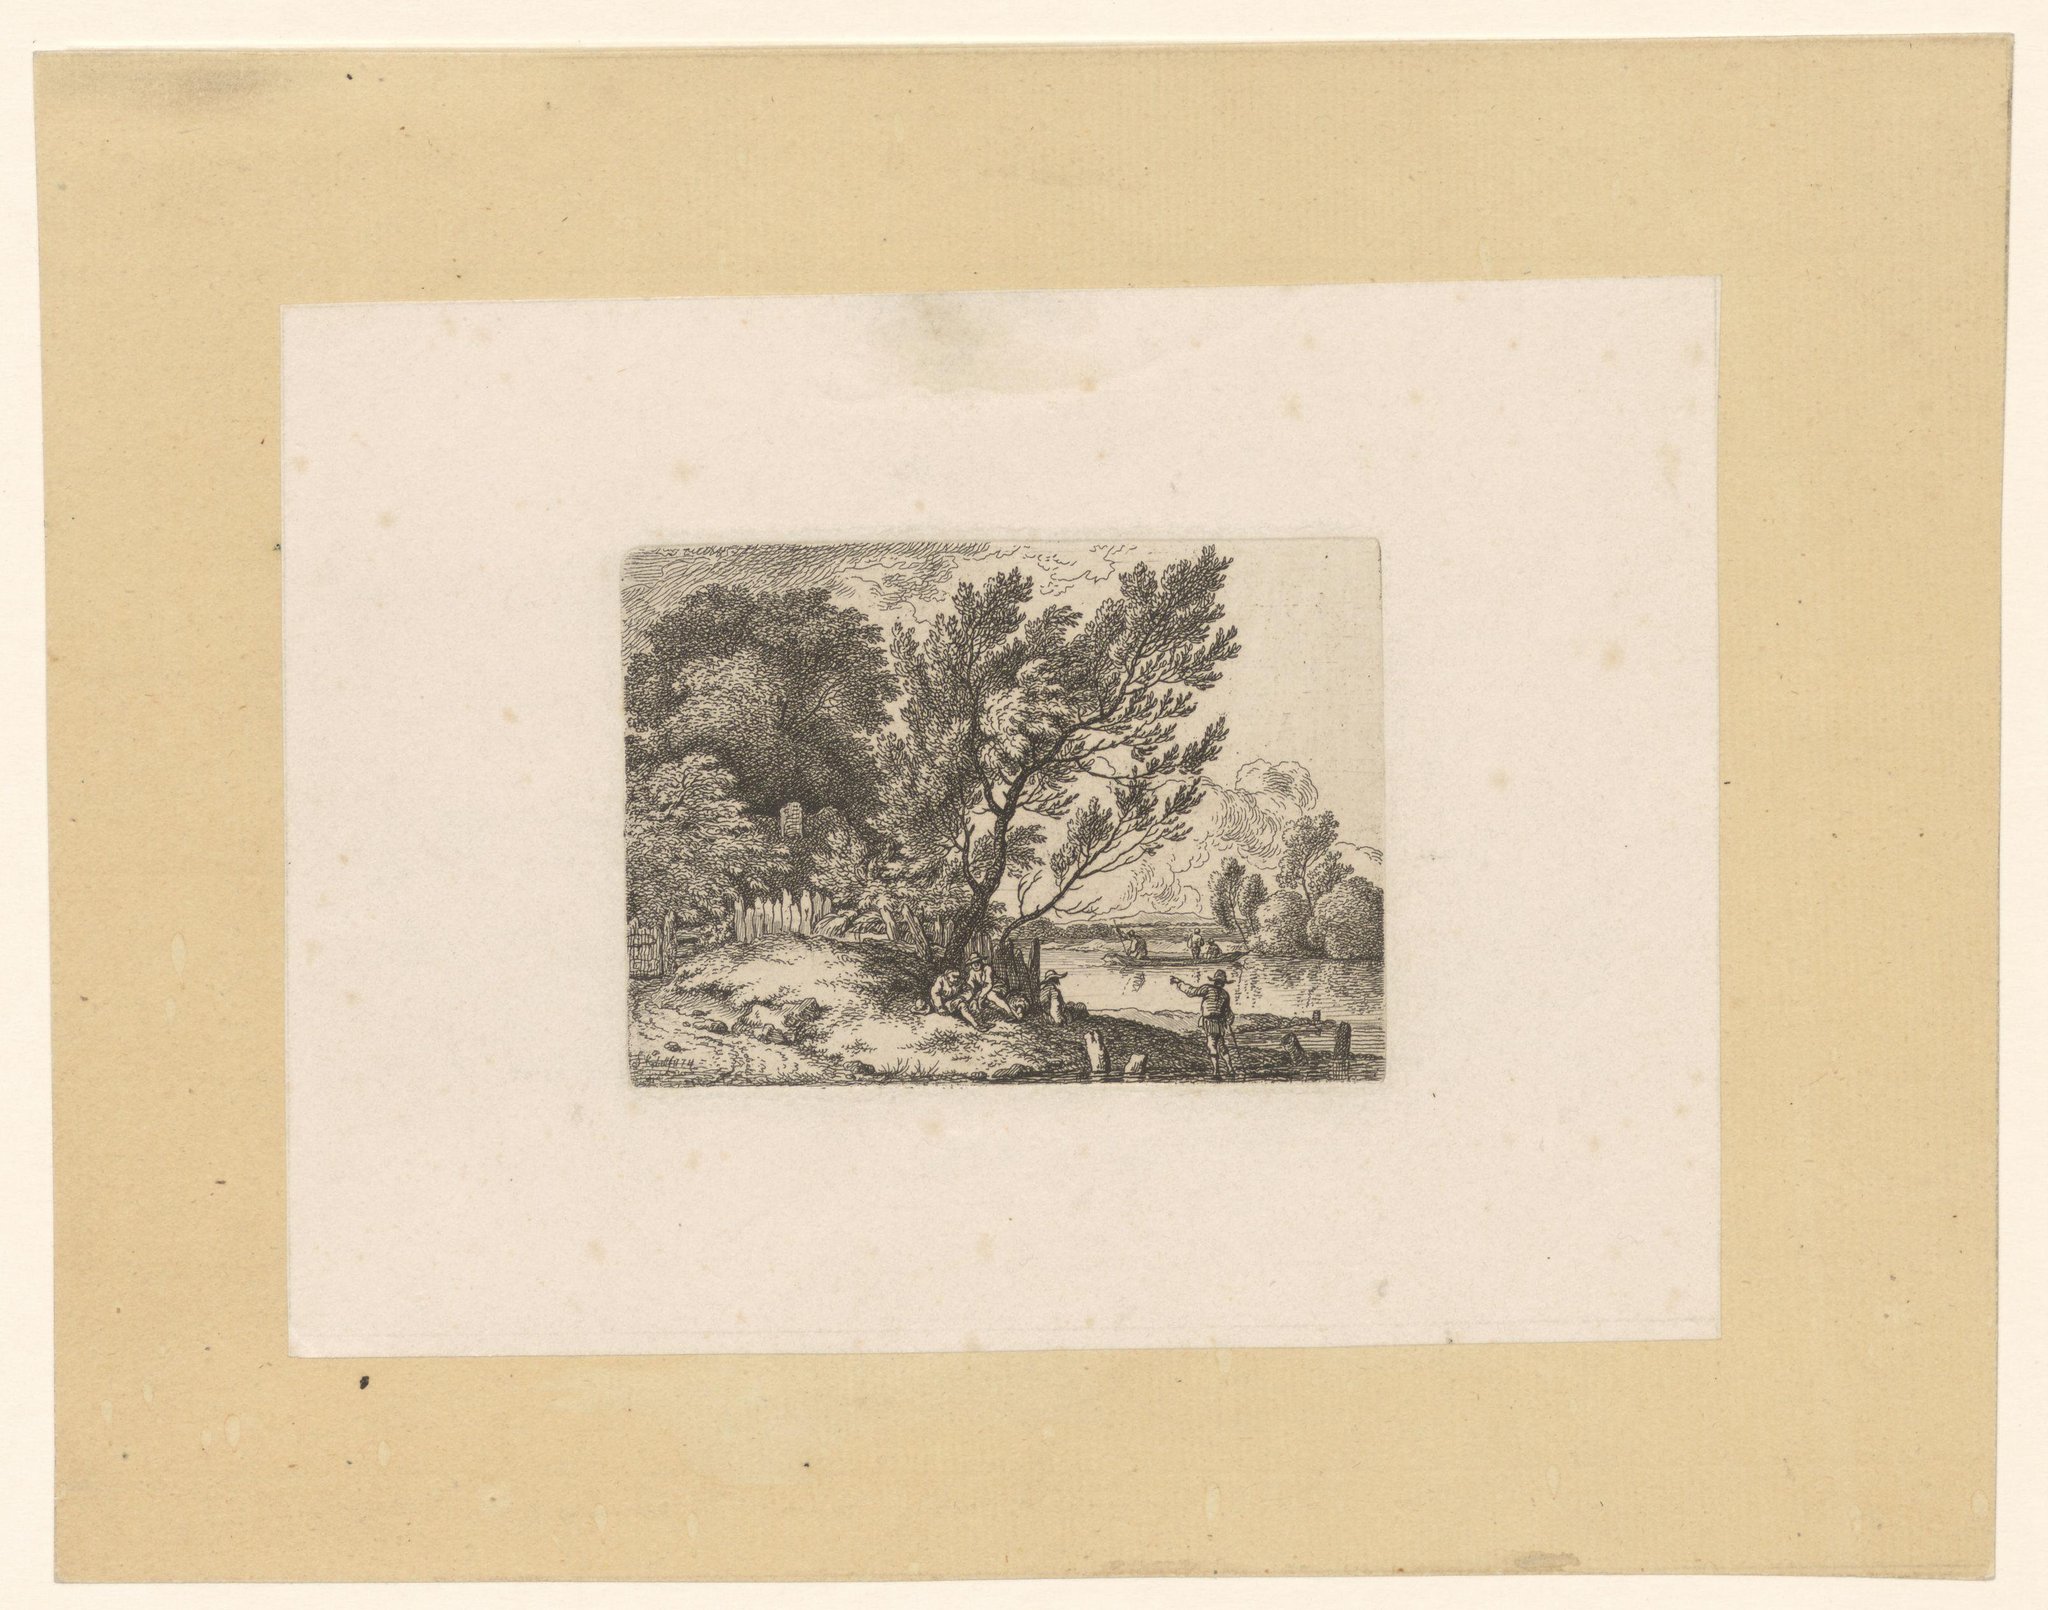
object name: print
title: Landschap met rustende figuren bij de oever van een rivier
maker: ferdinand kobell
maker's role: artist, painter, print maker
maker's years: 1740-1799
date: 1774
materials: paper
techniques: etching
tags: river bank, (traveller) resting in the open air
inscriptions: collector's mark: Lugt 2228